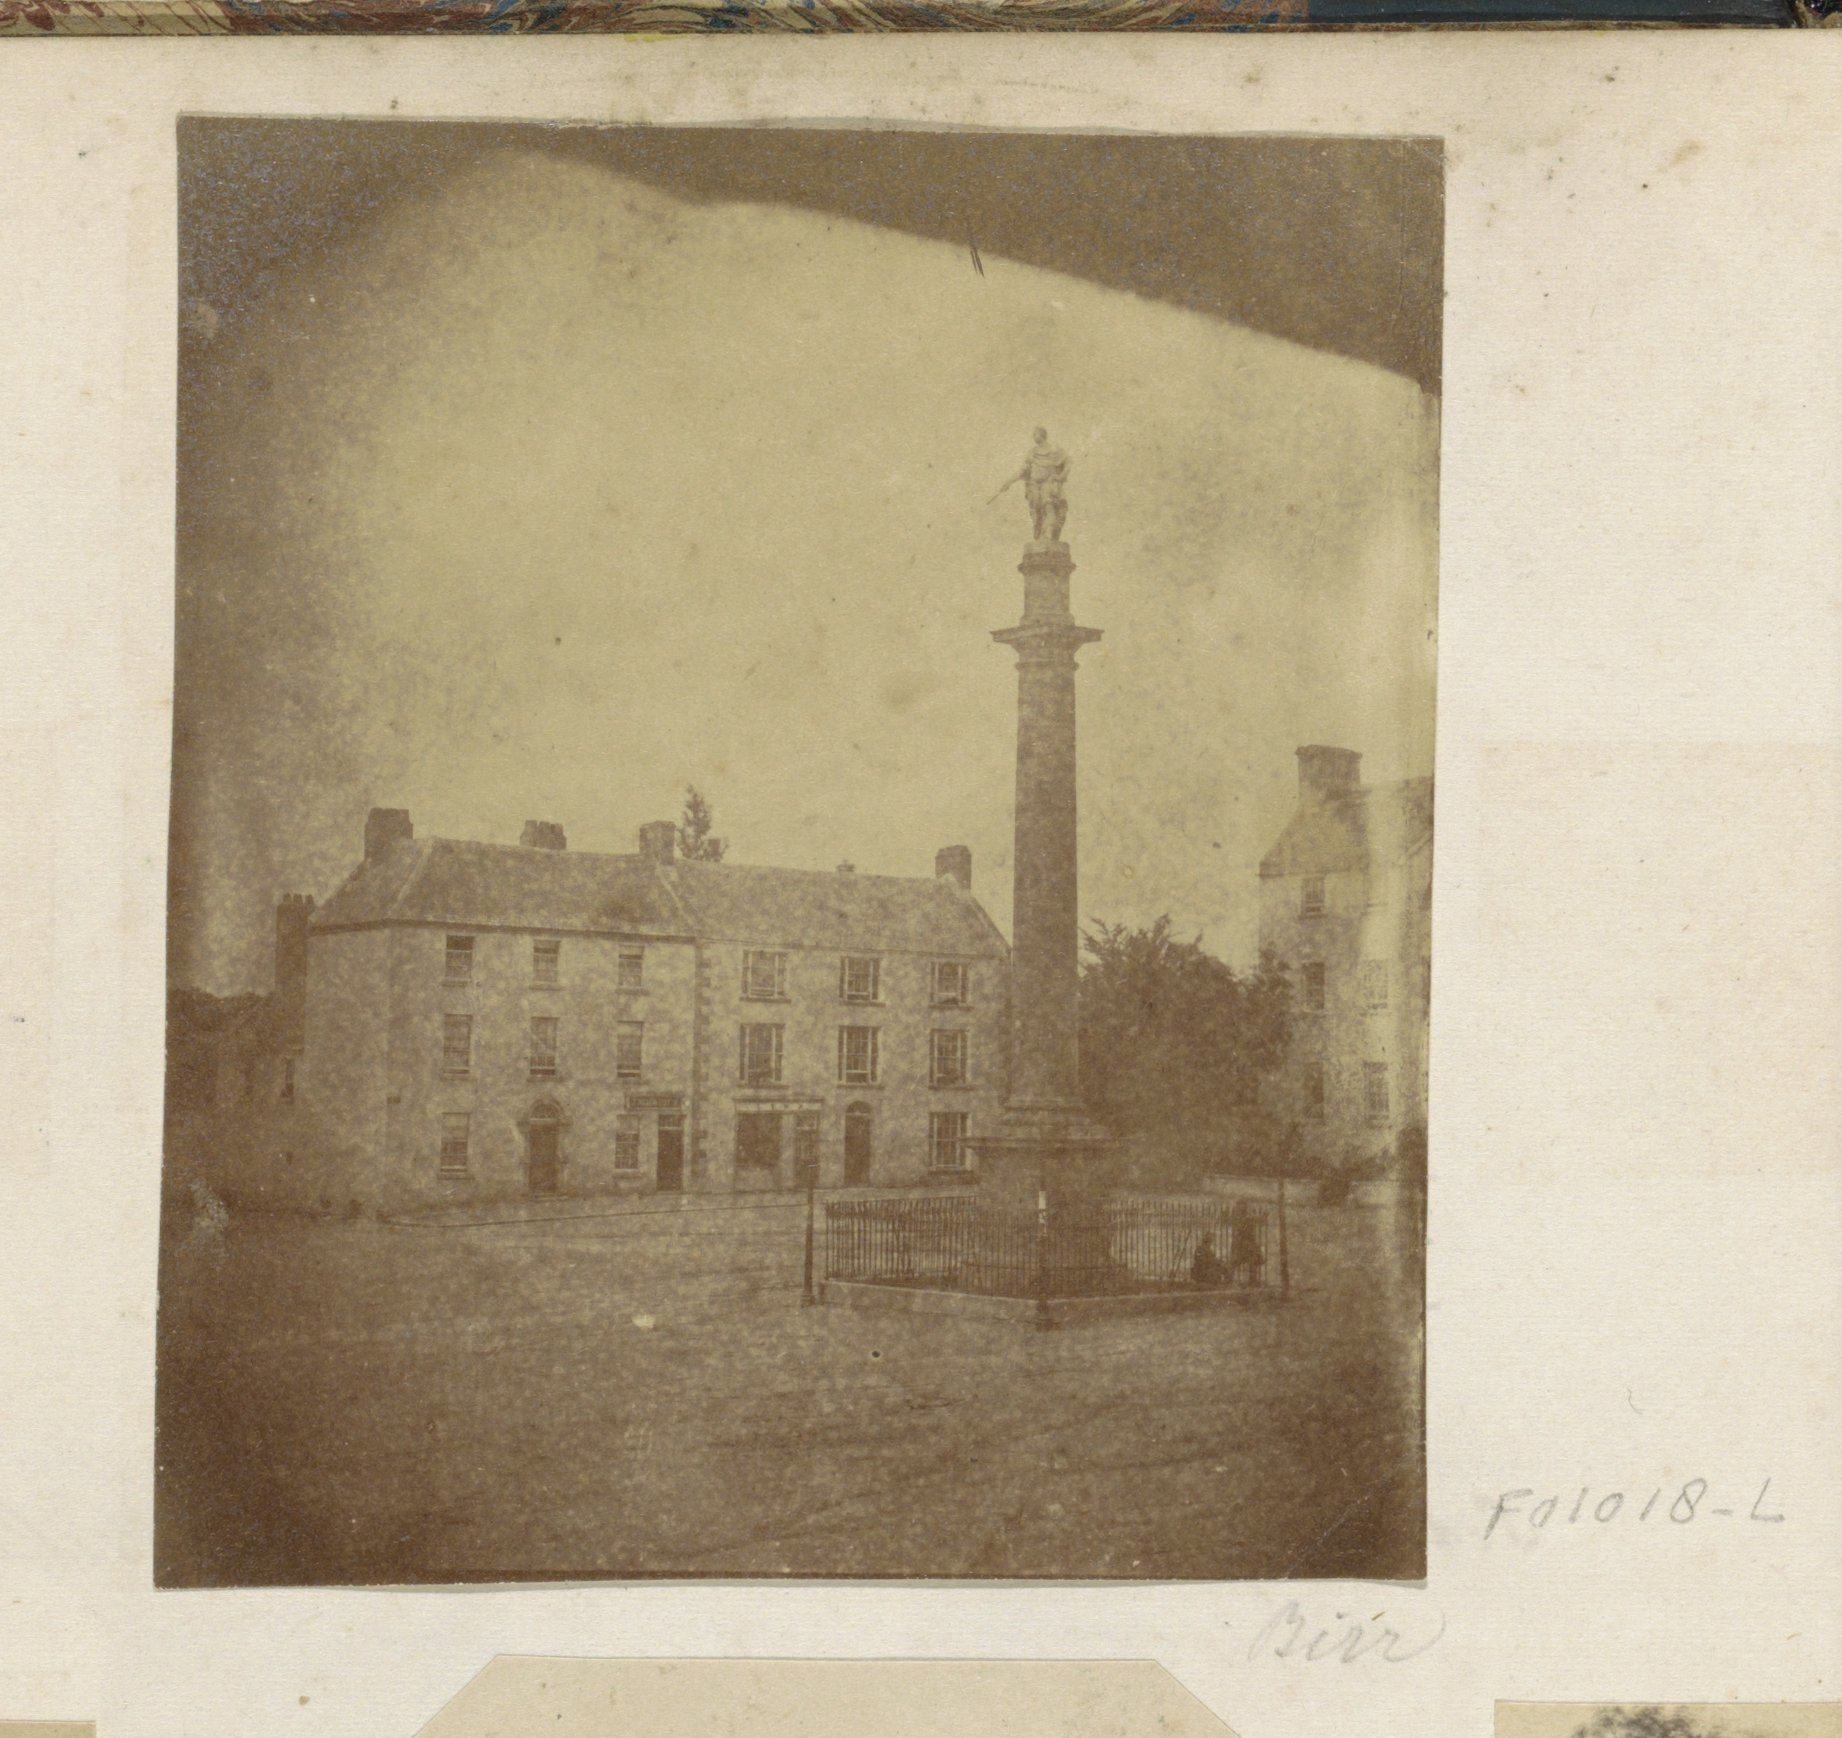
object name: photograph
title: Gezicht op een plein met een triomfzuil in Birr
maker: Anonymous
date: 1860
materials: paper, photographic support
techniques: albumen print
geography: birr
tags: square, place, circus, etc., triumphal arch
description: Onderdeel van Engels familiealbum met foto's van personen, reizen, cricket en kunstwerken.